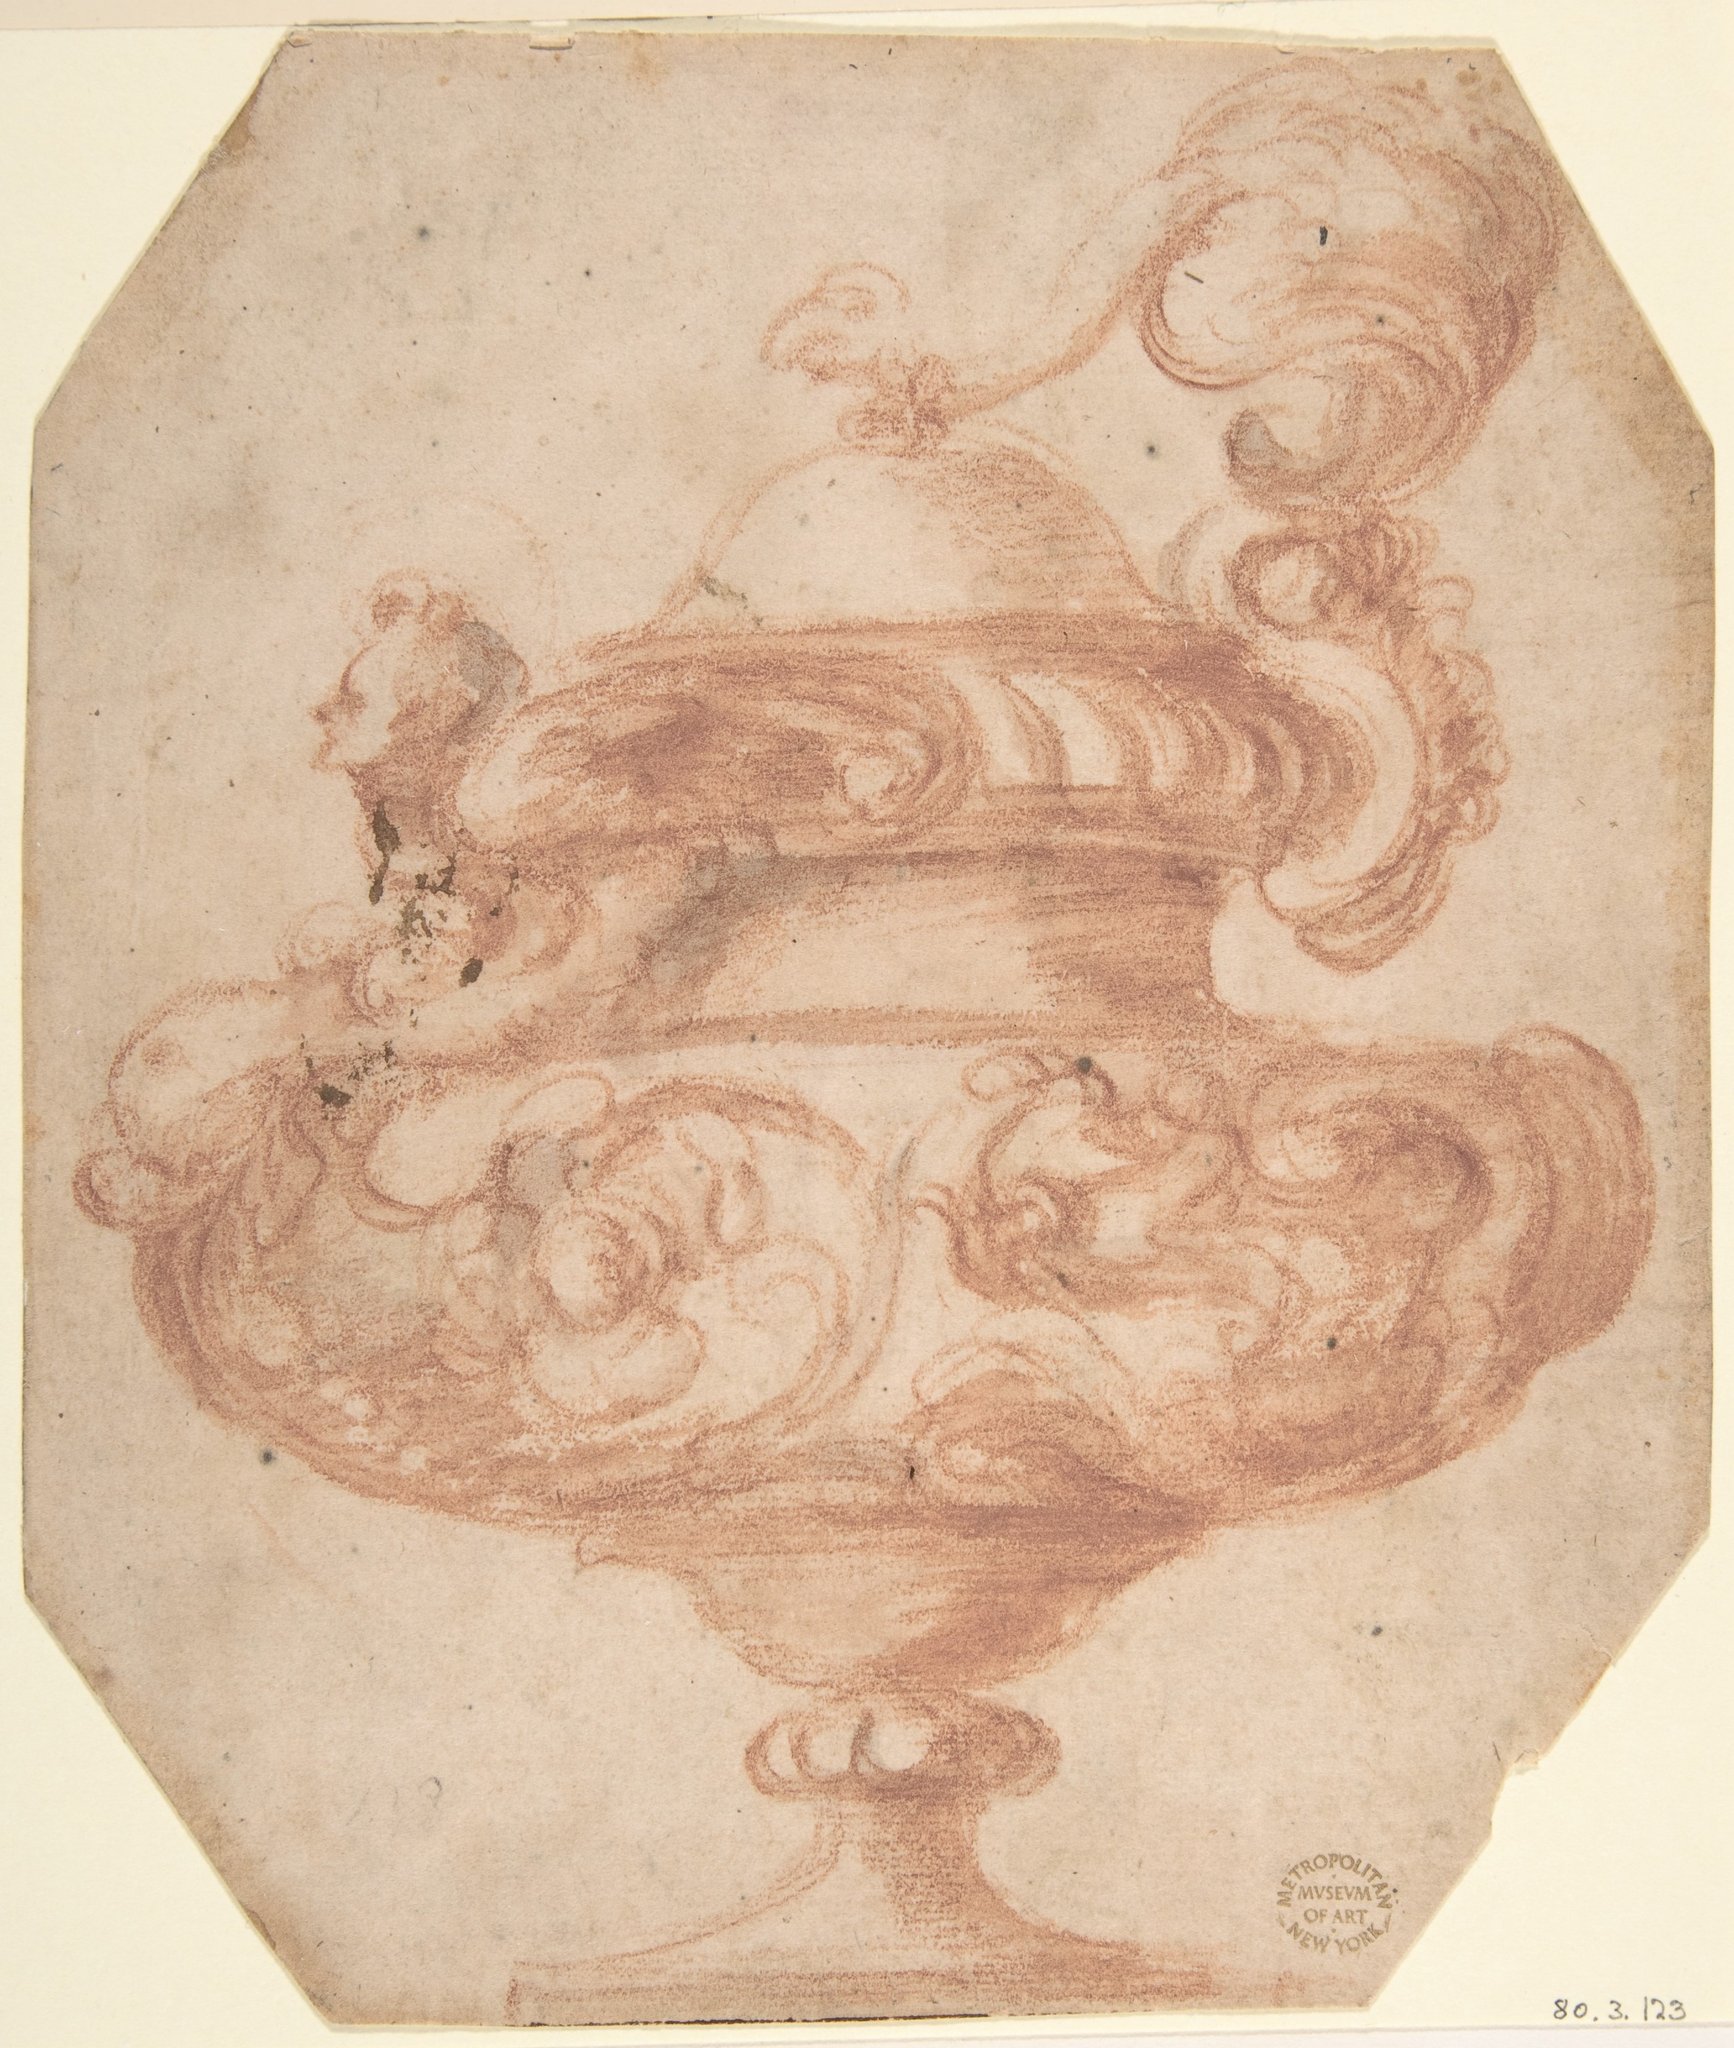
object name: drawing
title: A Vase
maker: anonymous, italian, 16th century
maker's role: artist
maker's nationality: italian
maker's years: 1550-1600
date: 1501-1600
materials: chalk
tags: vases